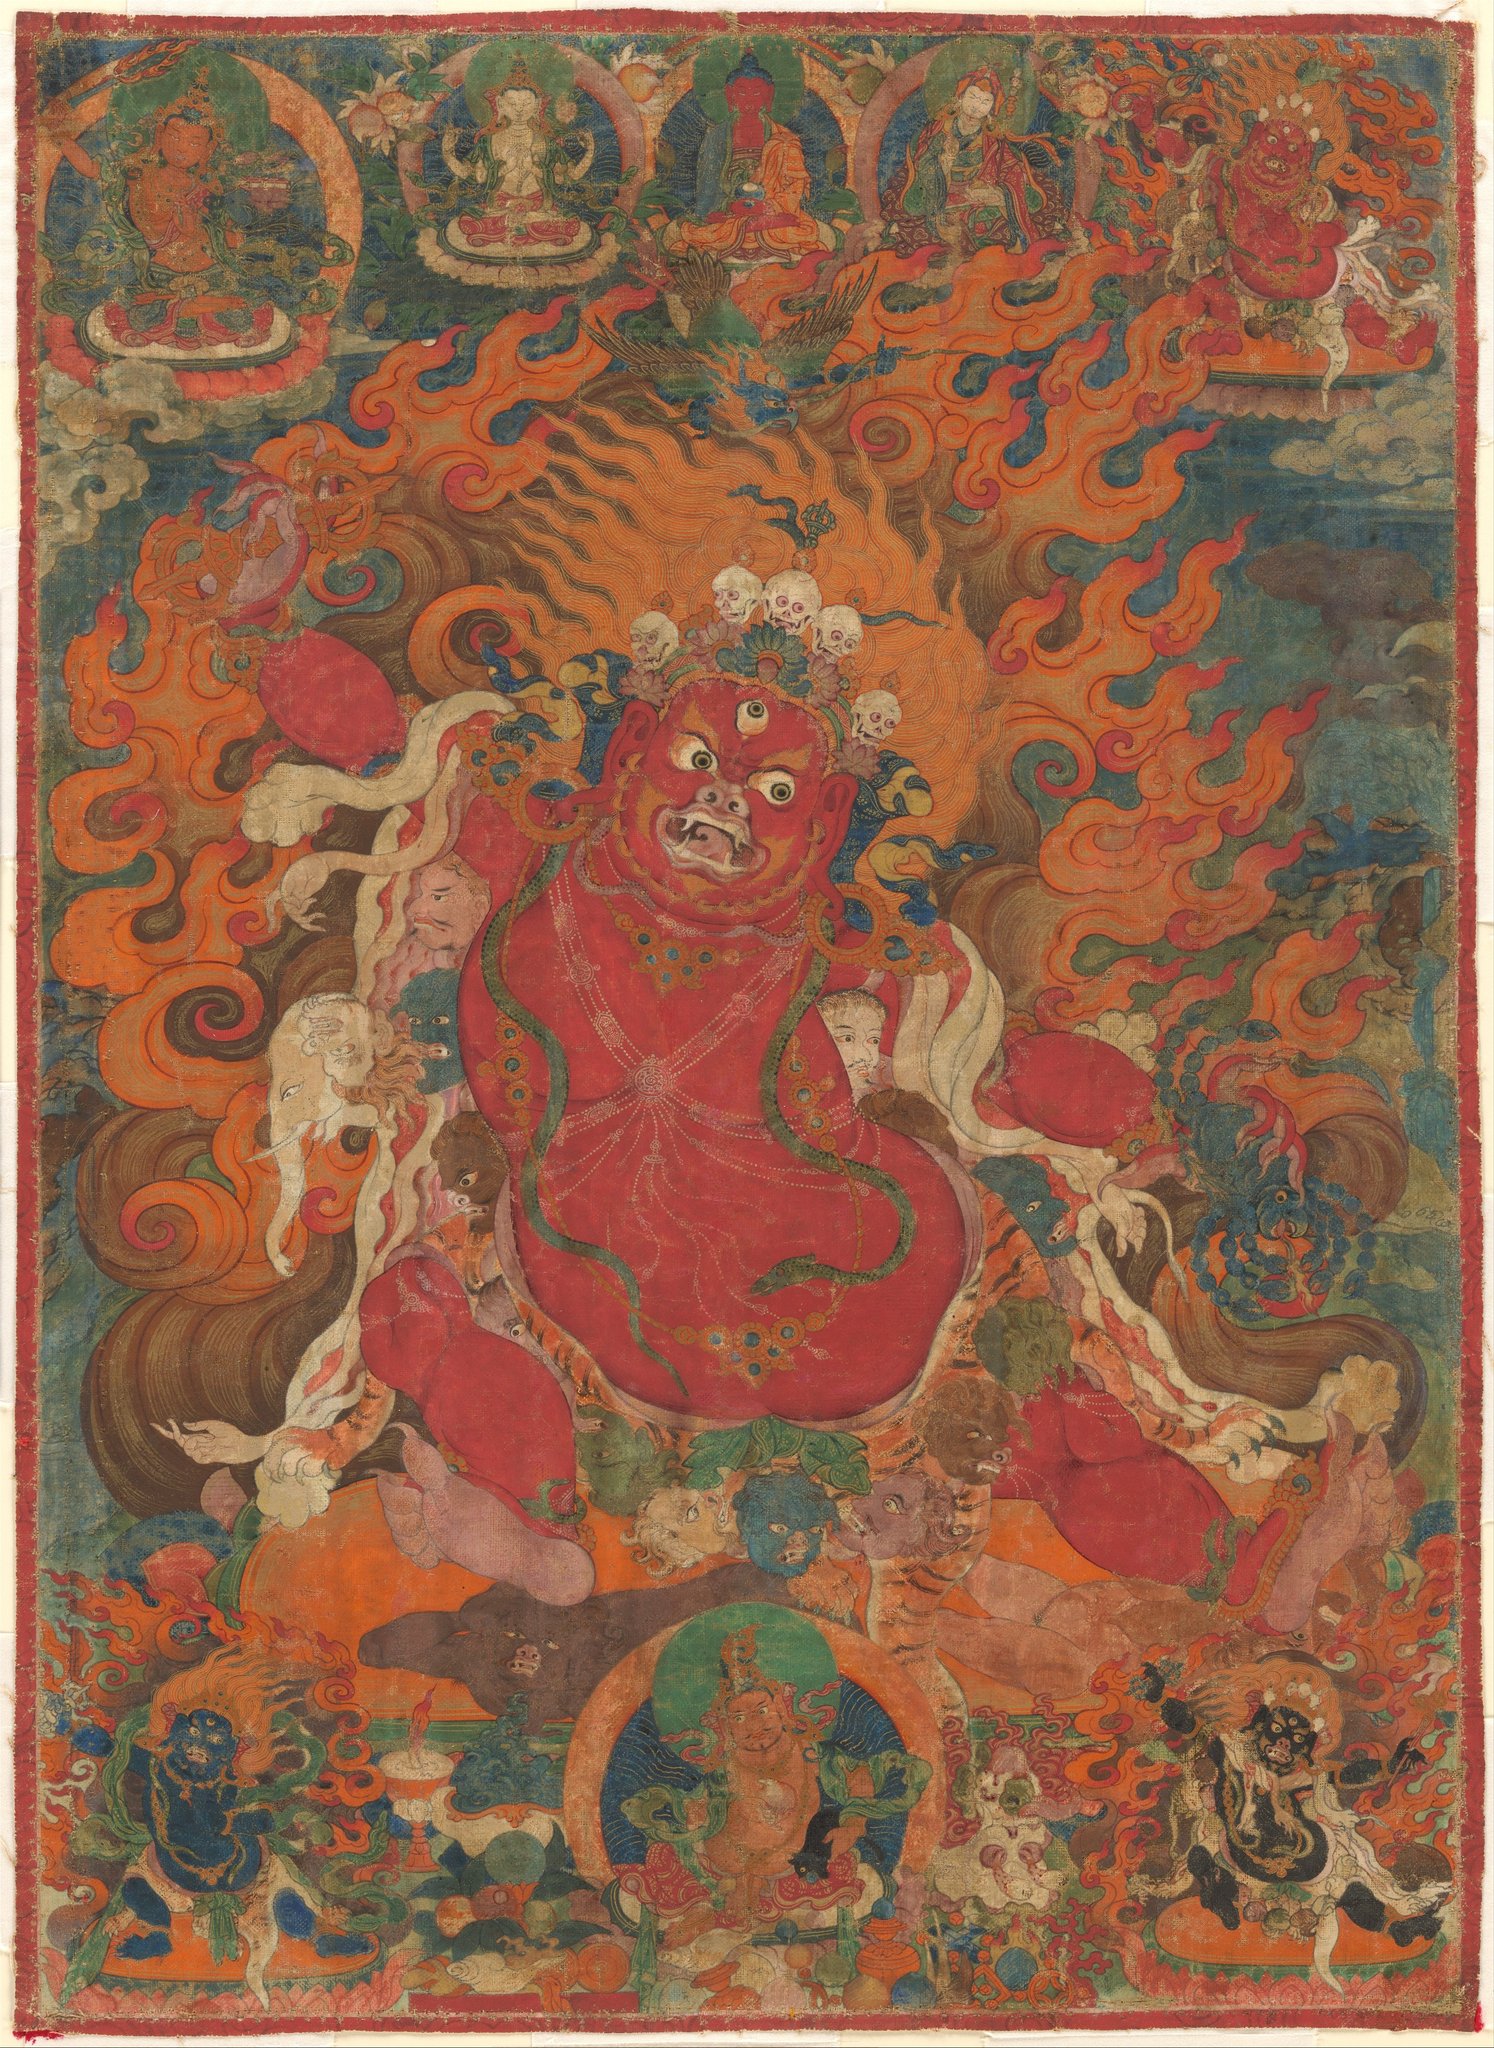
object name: thangka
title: Guru Dragpo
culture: tibetan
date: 1701-1800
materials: cotton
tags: skulls,elephants,buddhism,deities